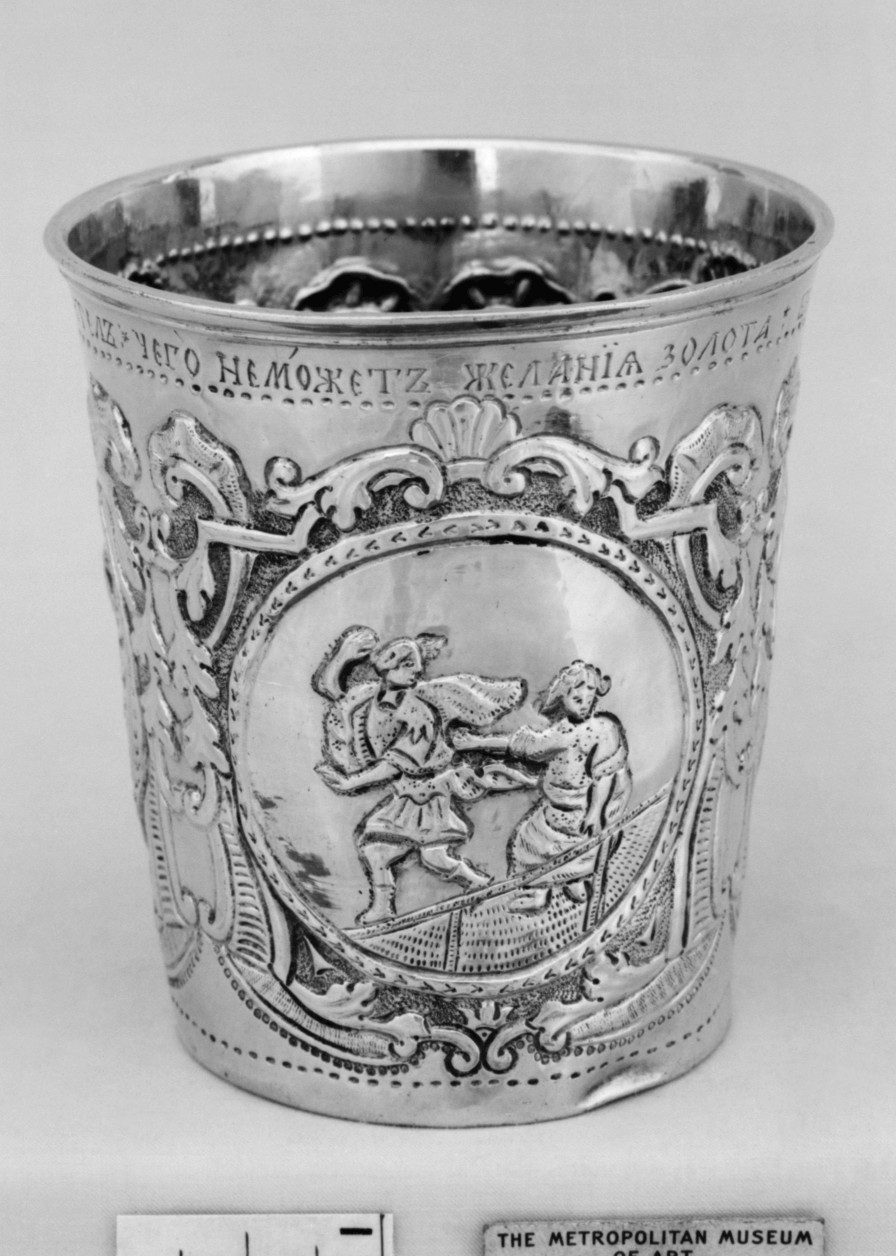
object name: beaker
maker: al'derman petrov fiodor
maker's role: maker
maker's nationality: russian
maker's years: 1759-1784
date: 1773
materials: gilt, silver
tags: human figures